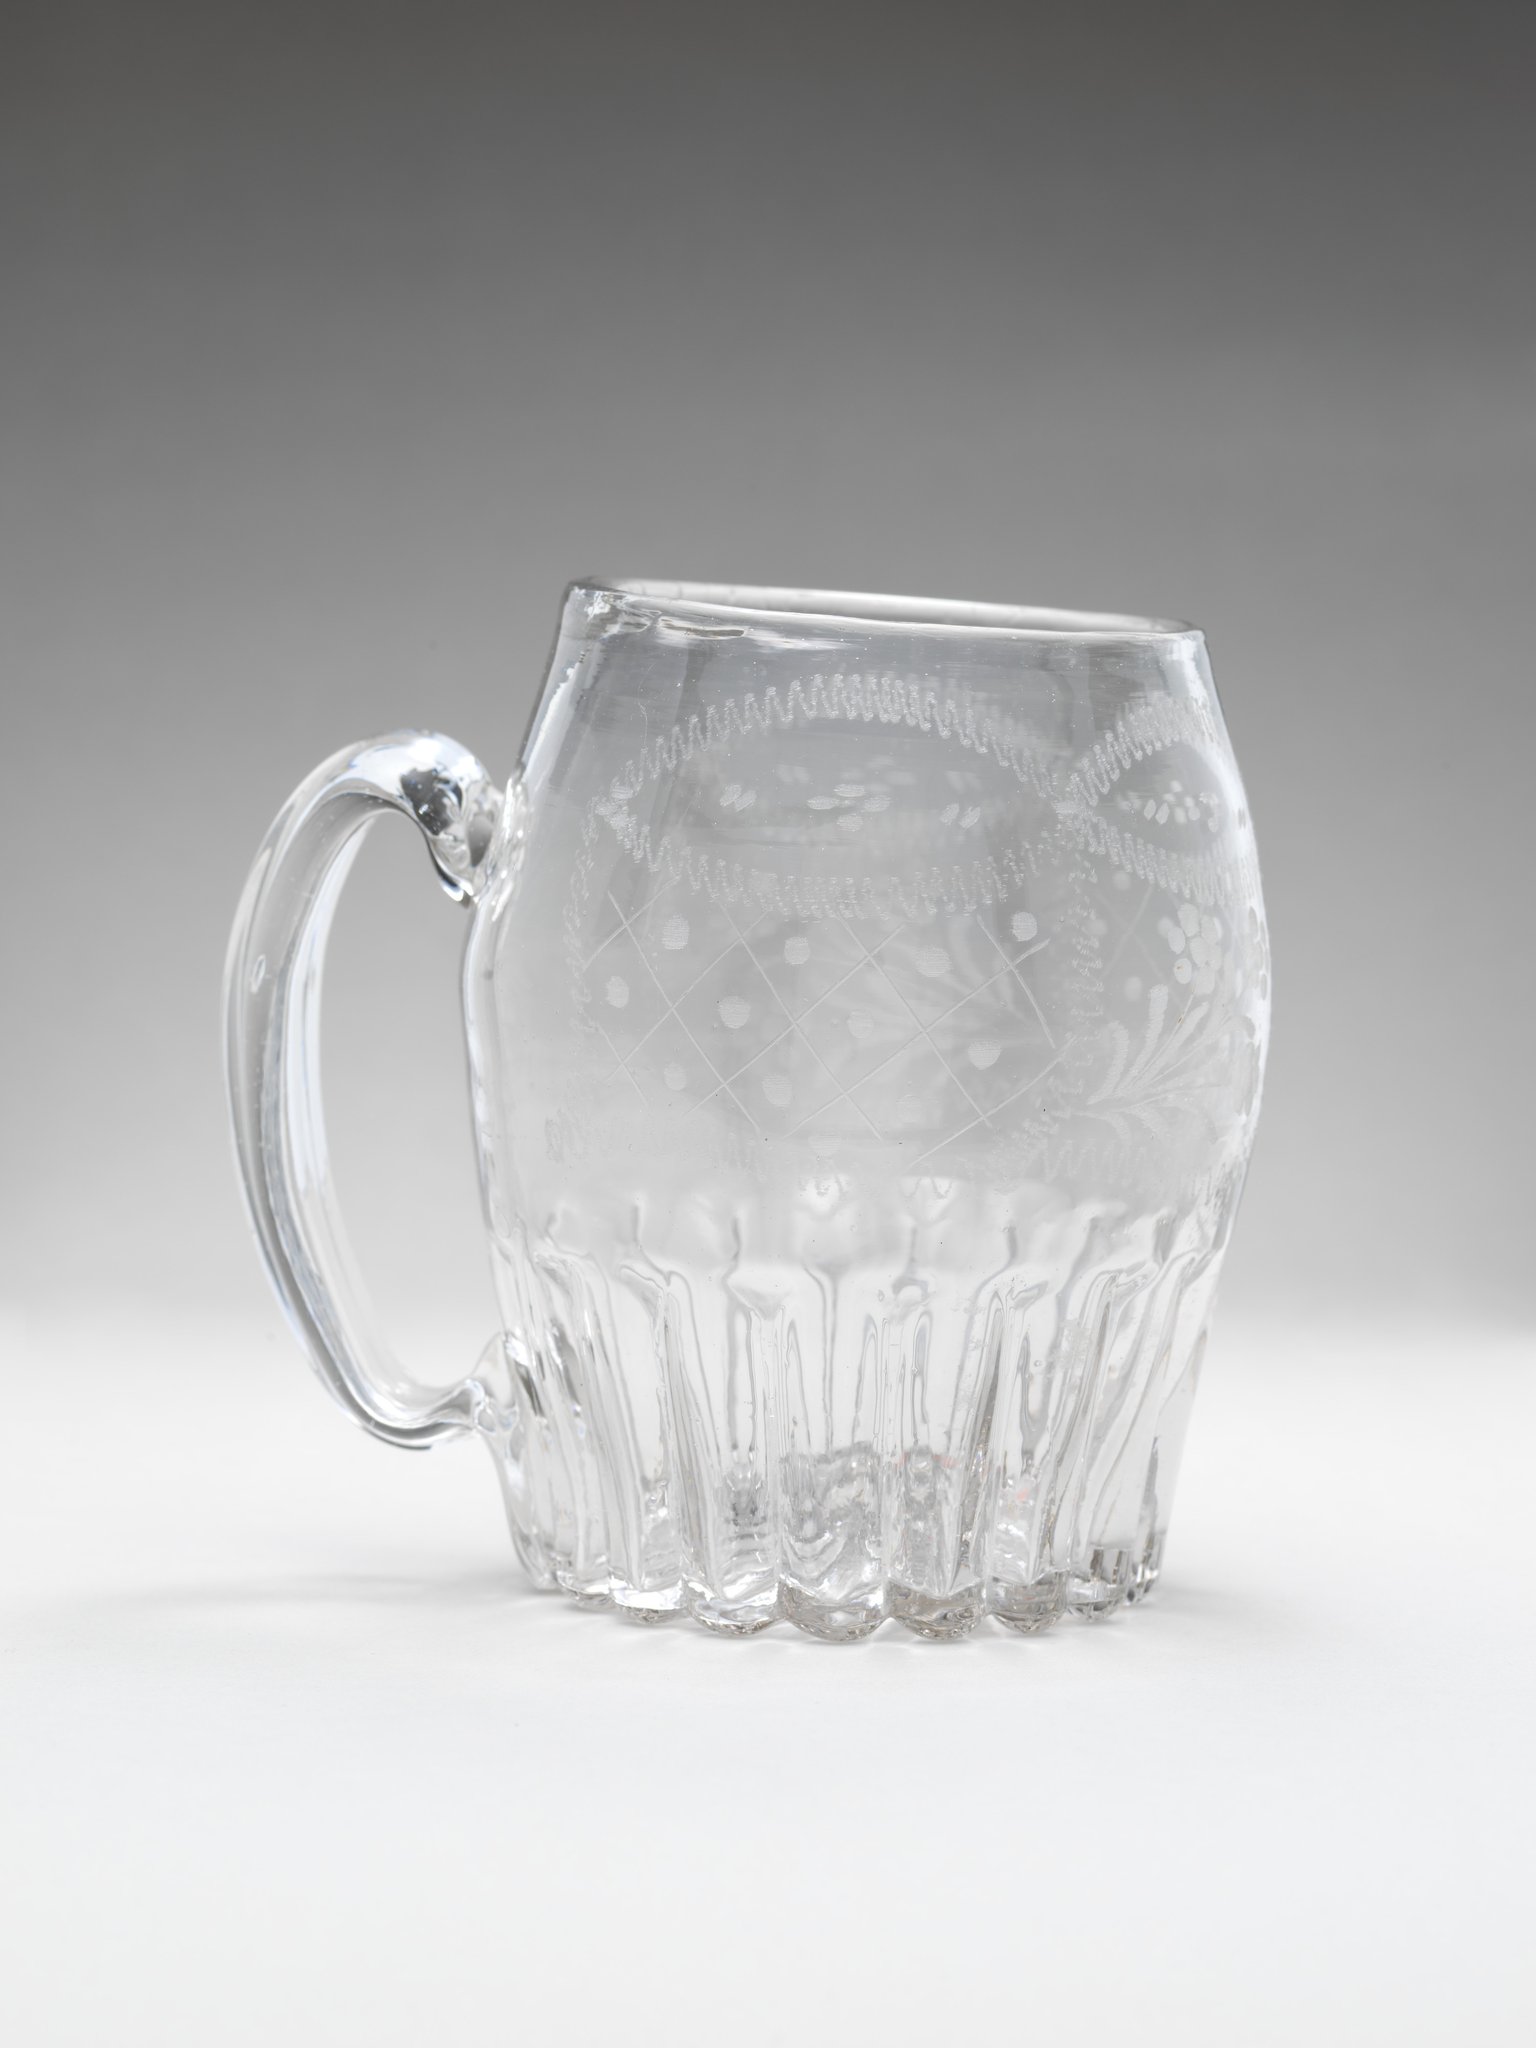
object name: jug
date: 1701-1800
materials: glass